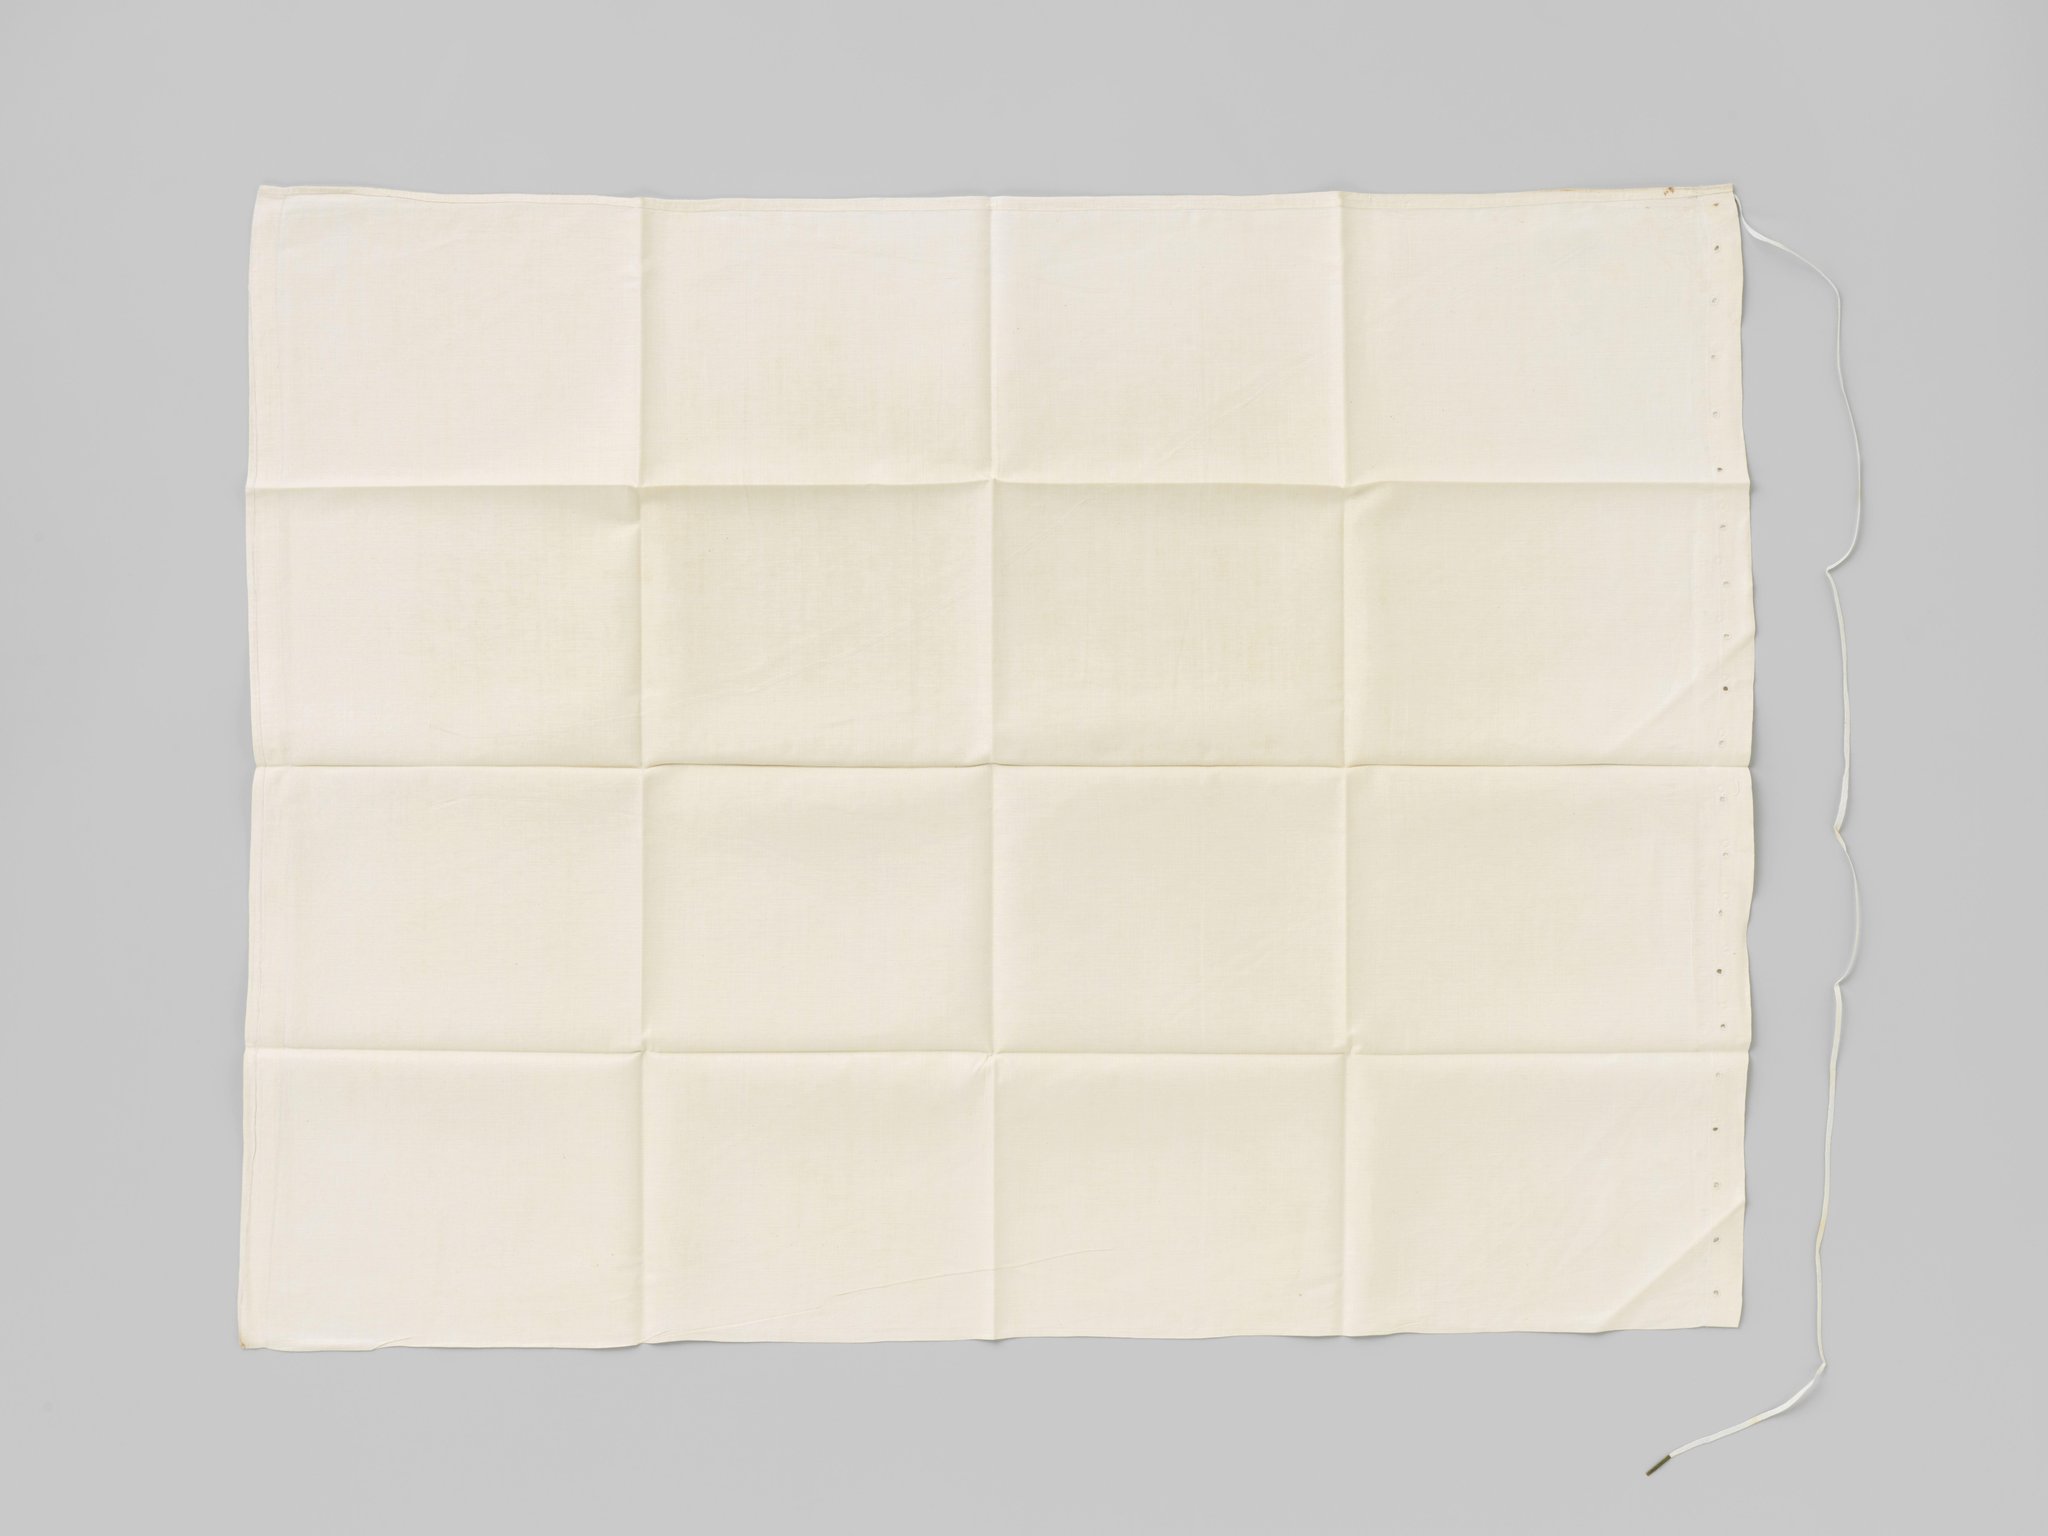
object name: pillowcase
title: Kussensloop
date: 1831-1875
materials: linen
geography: northern netherlands